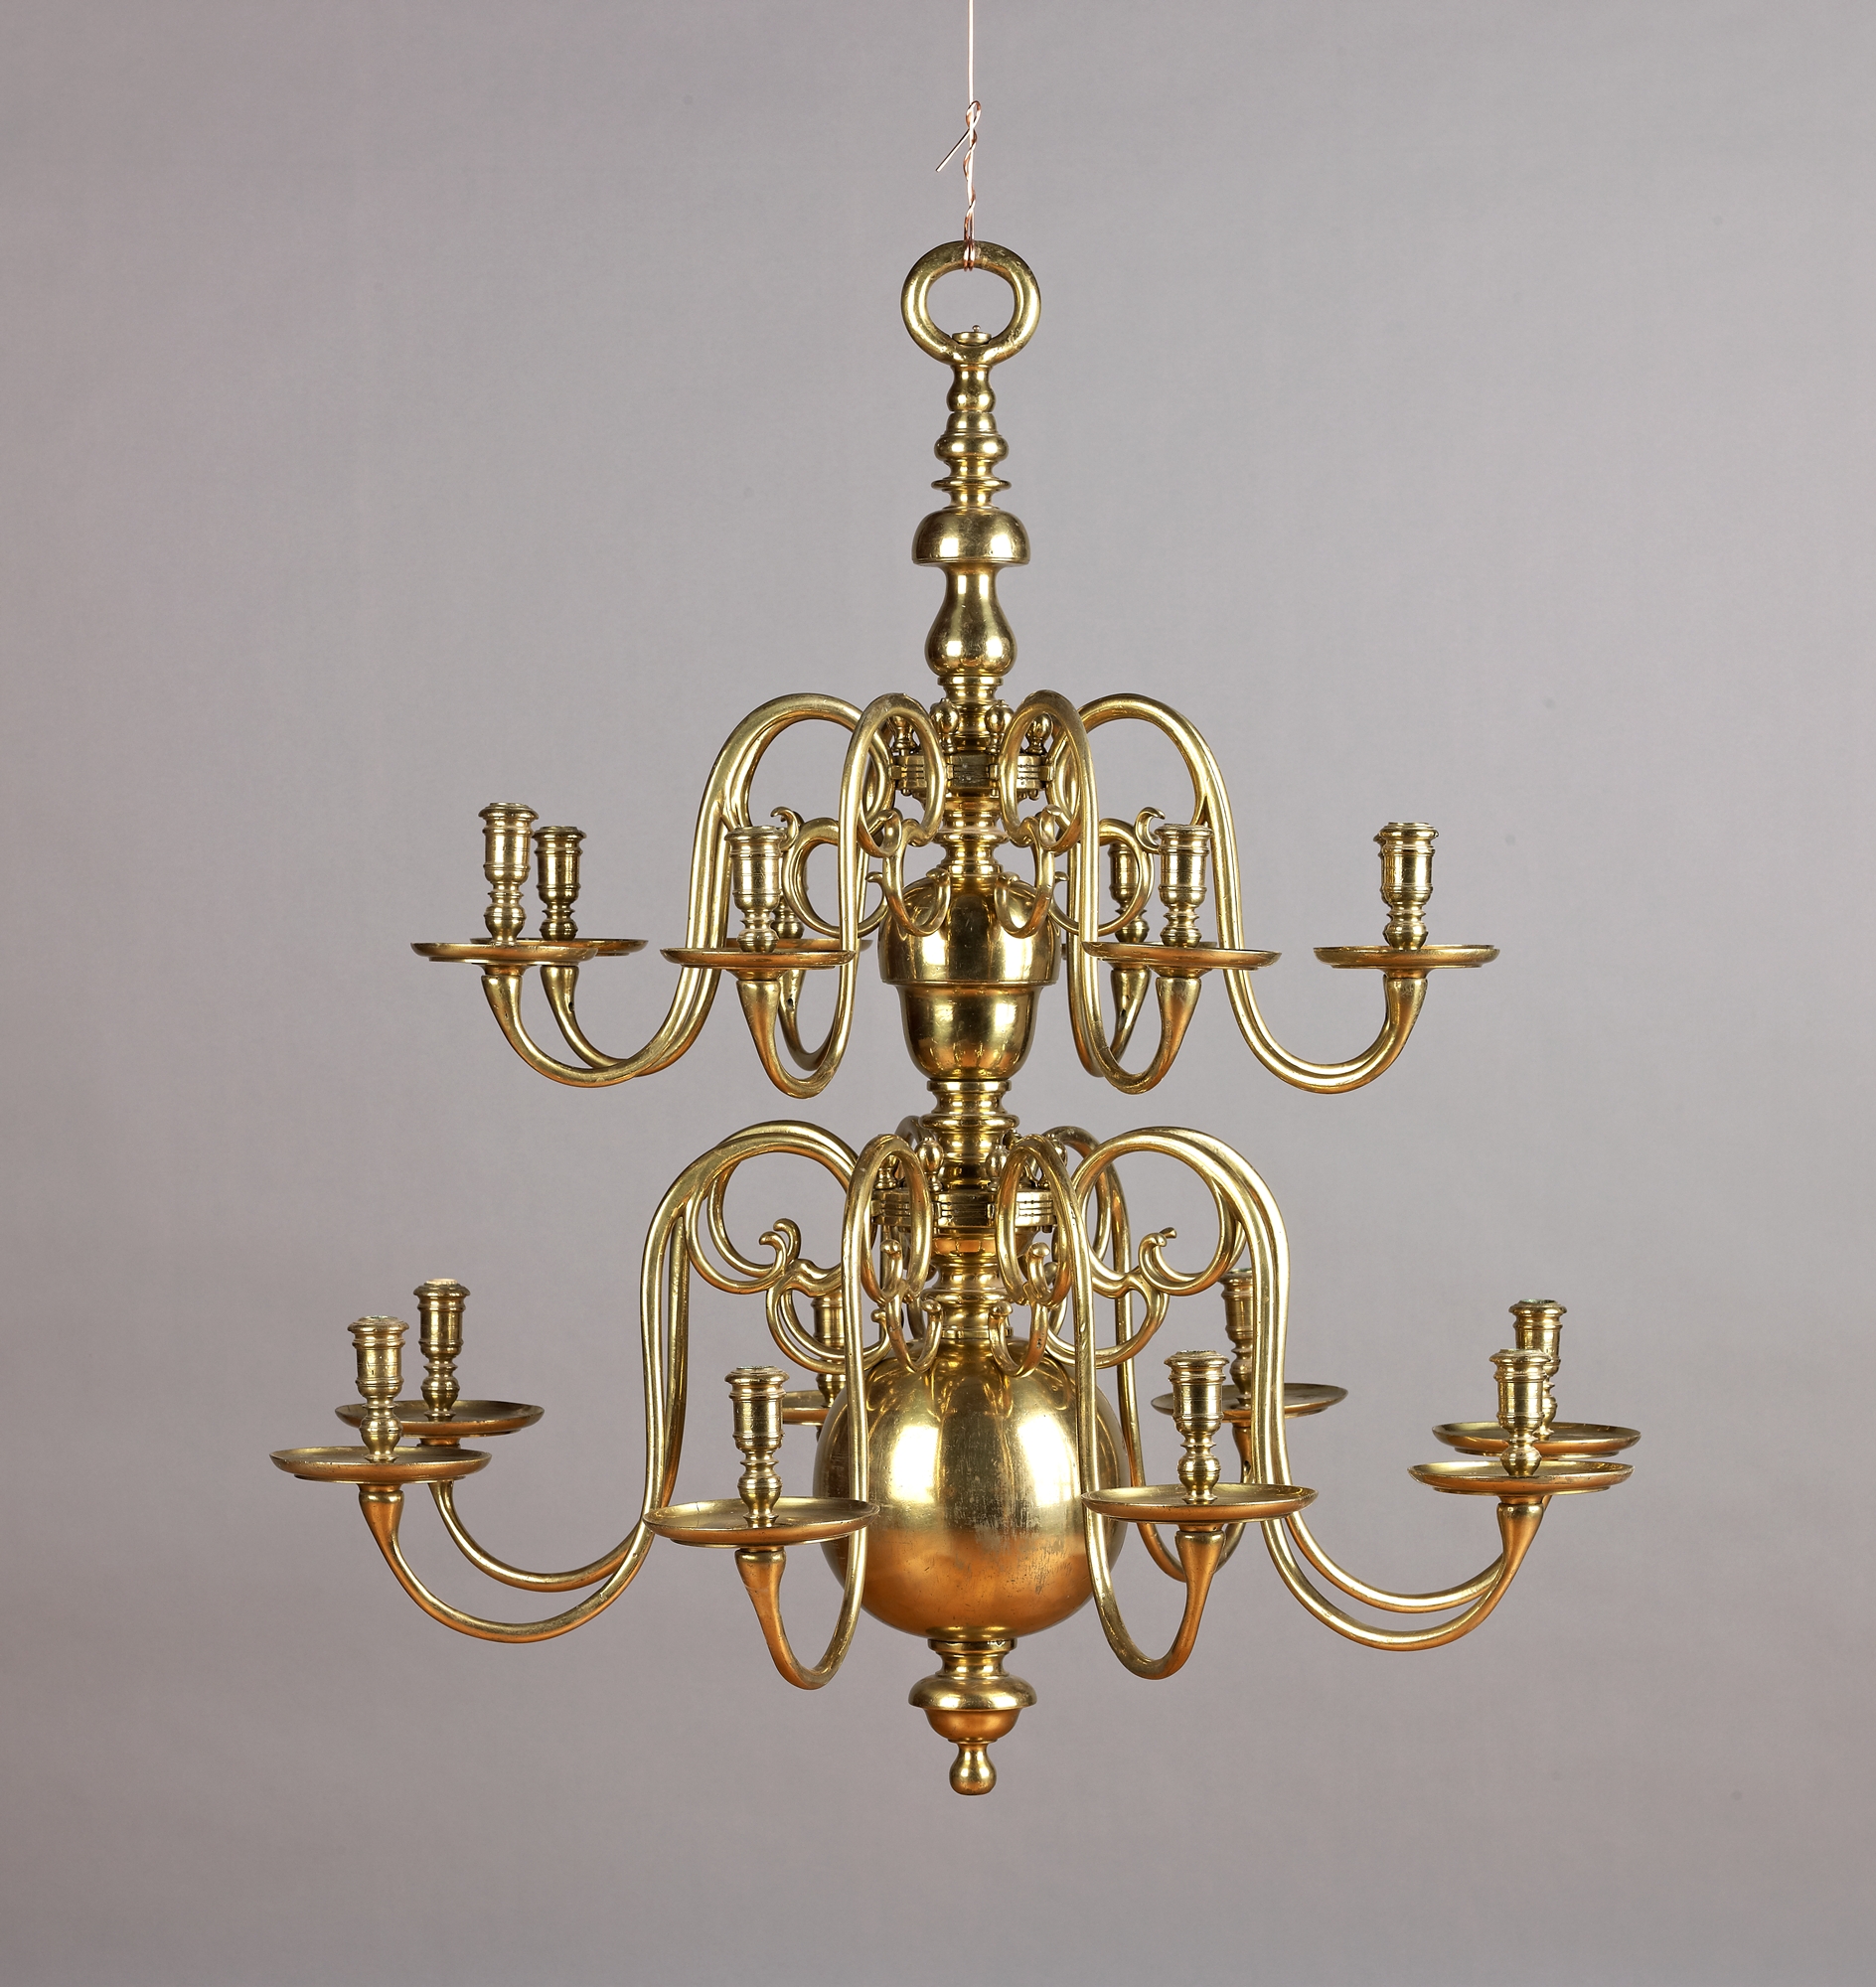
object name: chandelier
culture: dutch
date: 1701-1733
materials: brass